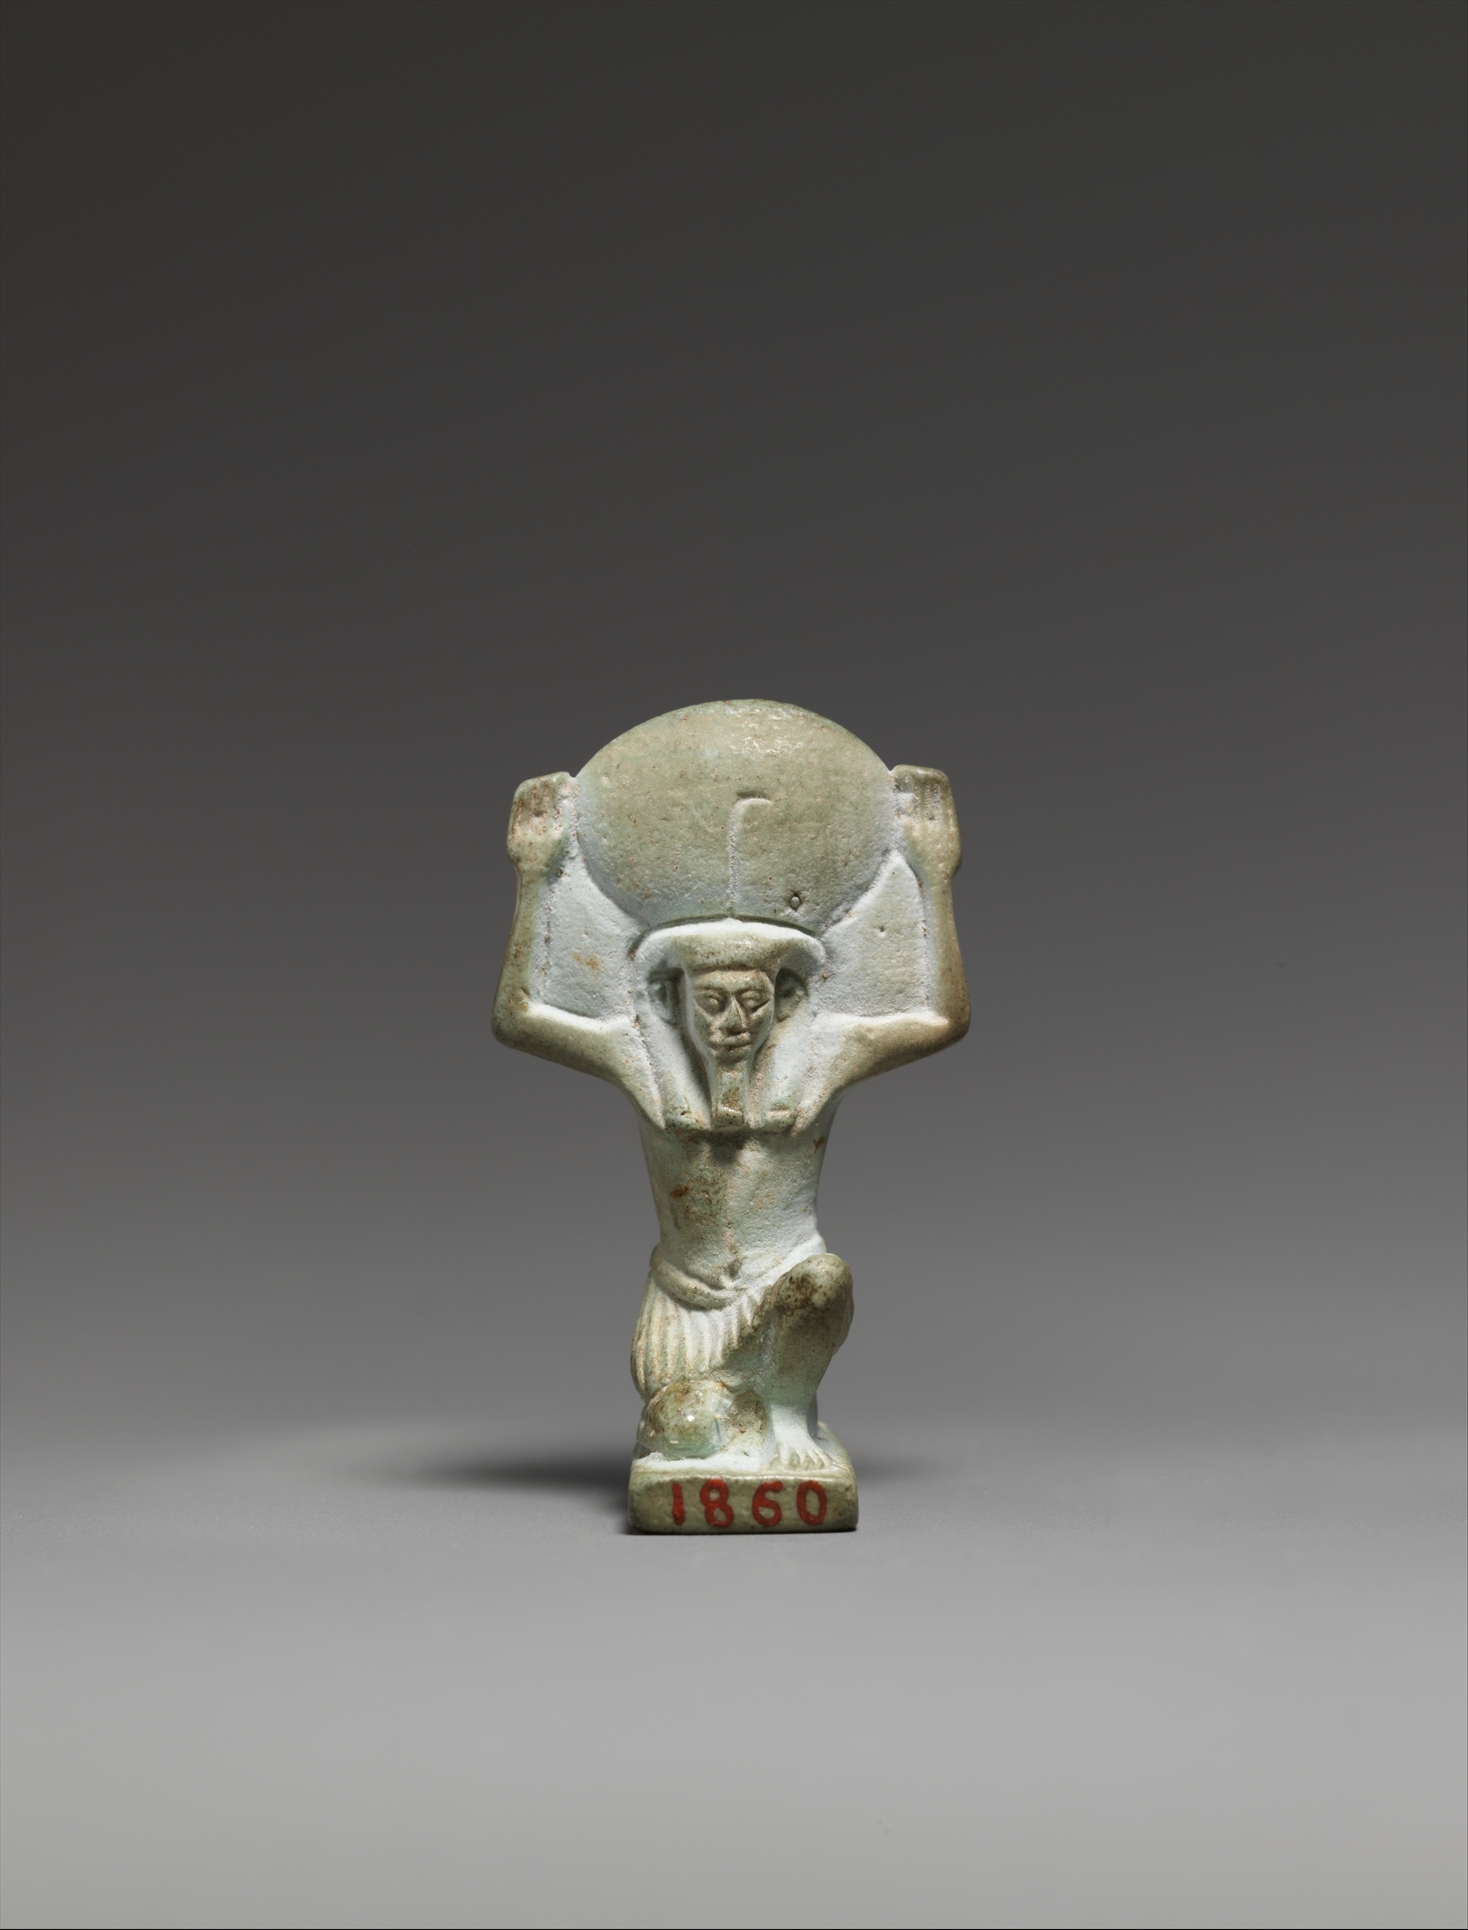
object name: amulet, shu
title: Shu Amulet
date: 664-332 BCE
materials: faience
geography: egypt